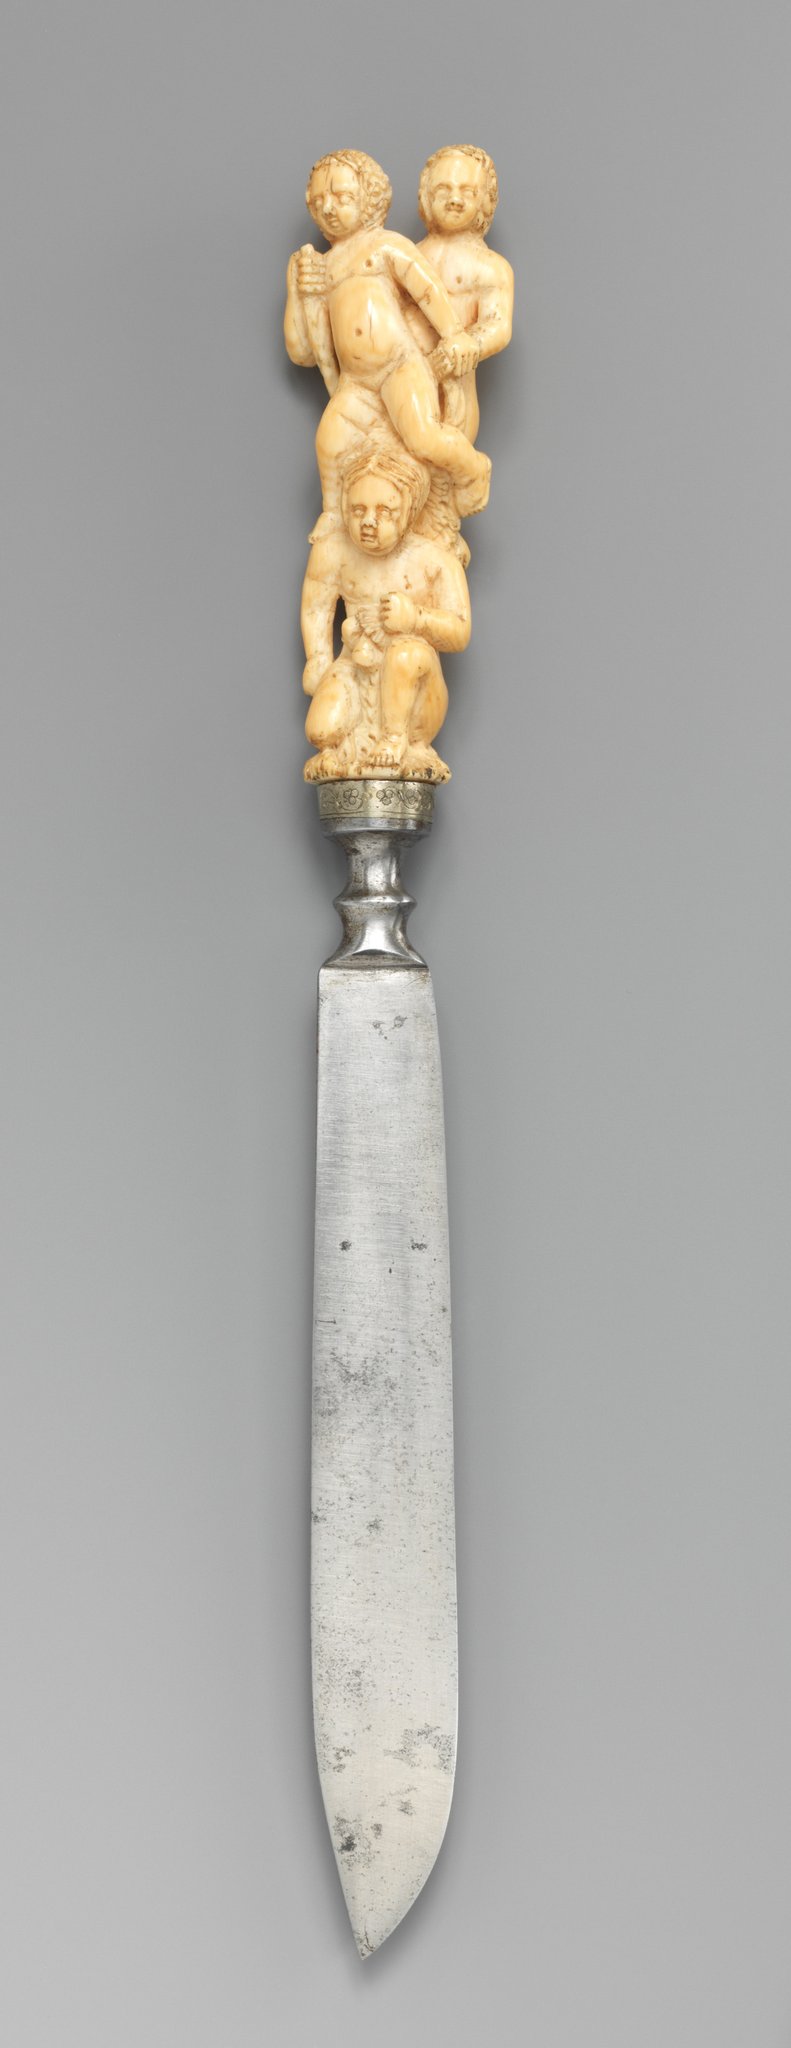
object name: knife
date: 1701-1750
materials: ivory, steel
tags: children